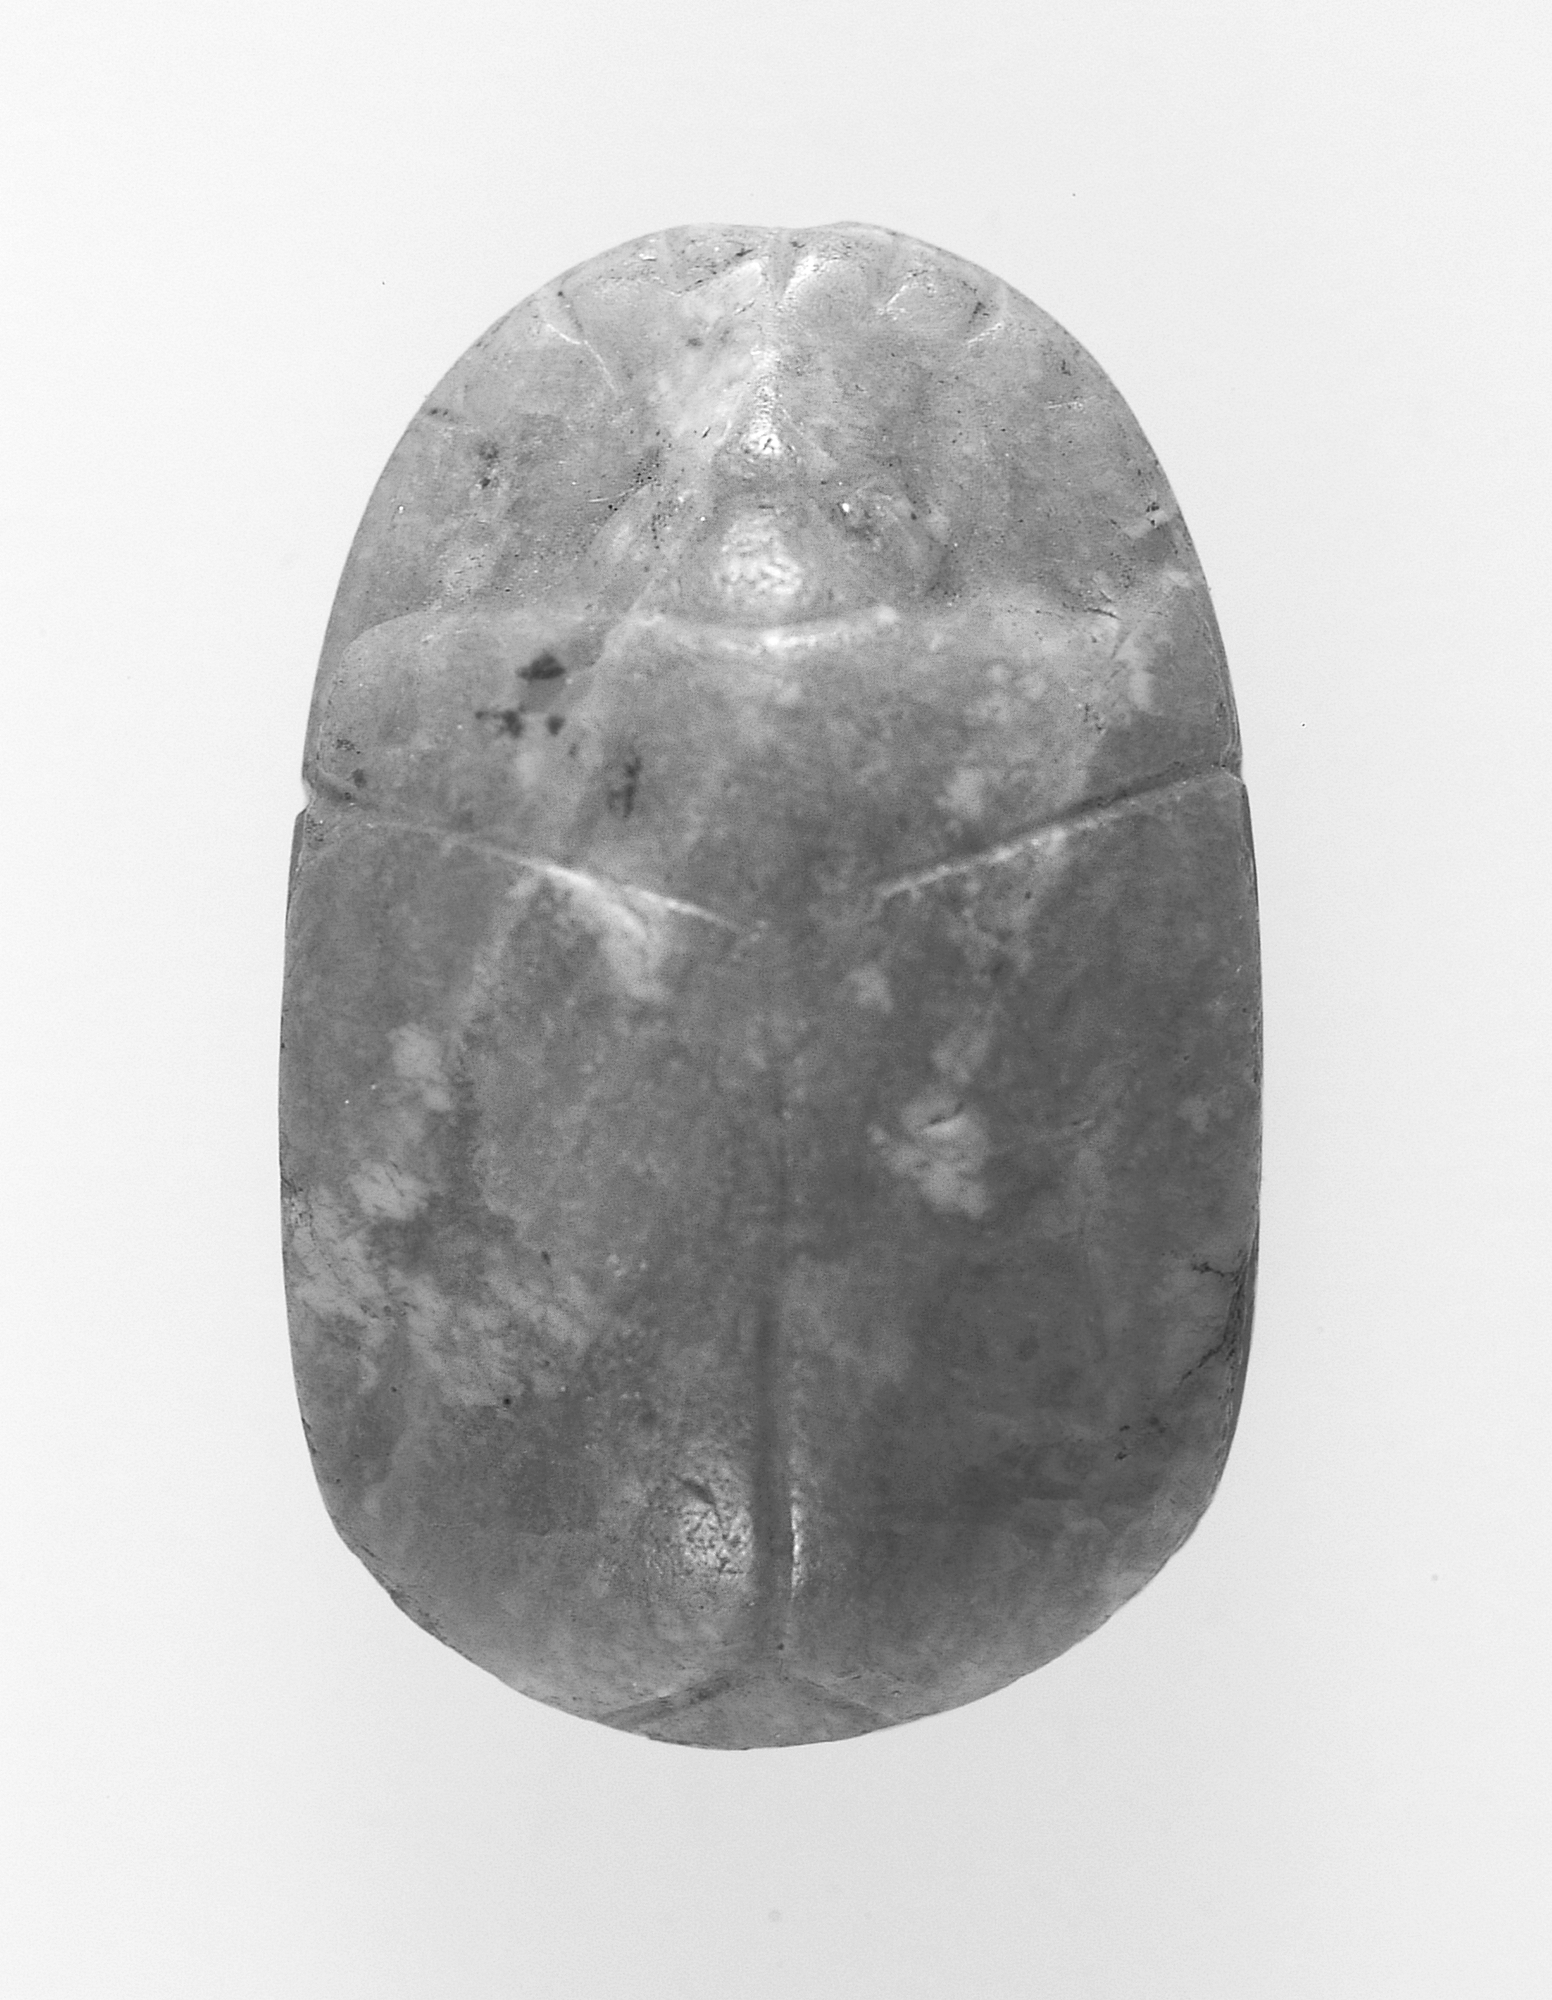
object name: scarab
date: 1640-1550 BCE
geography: egypt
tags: scarabs